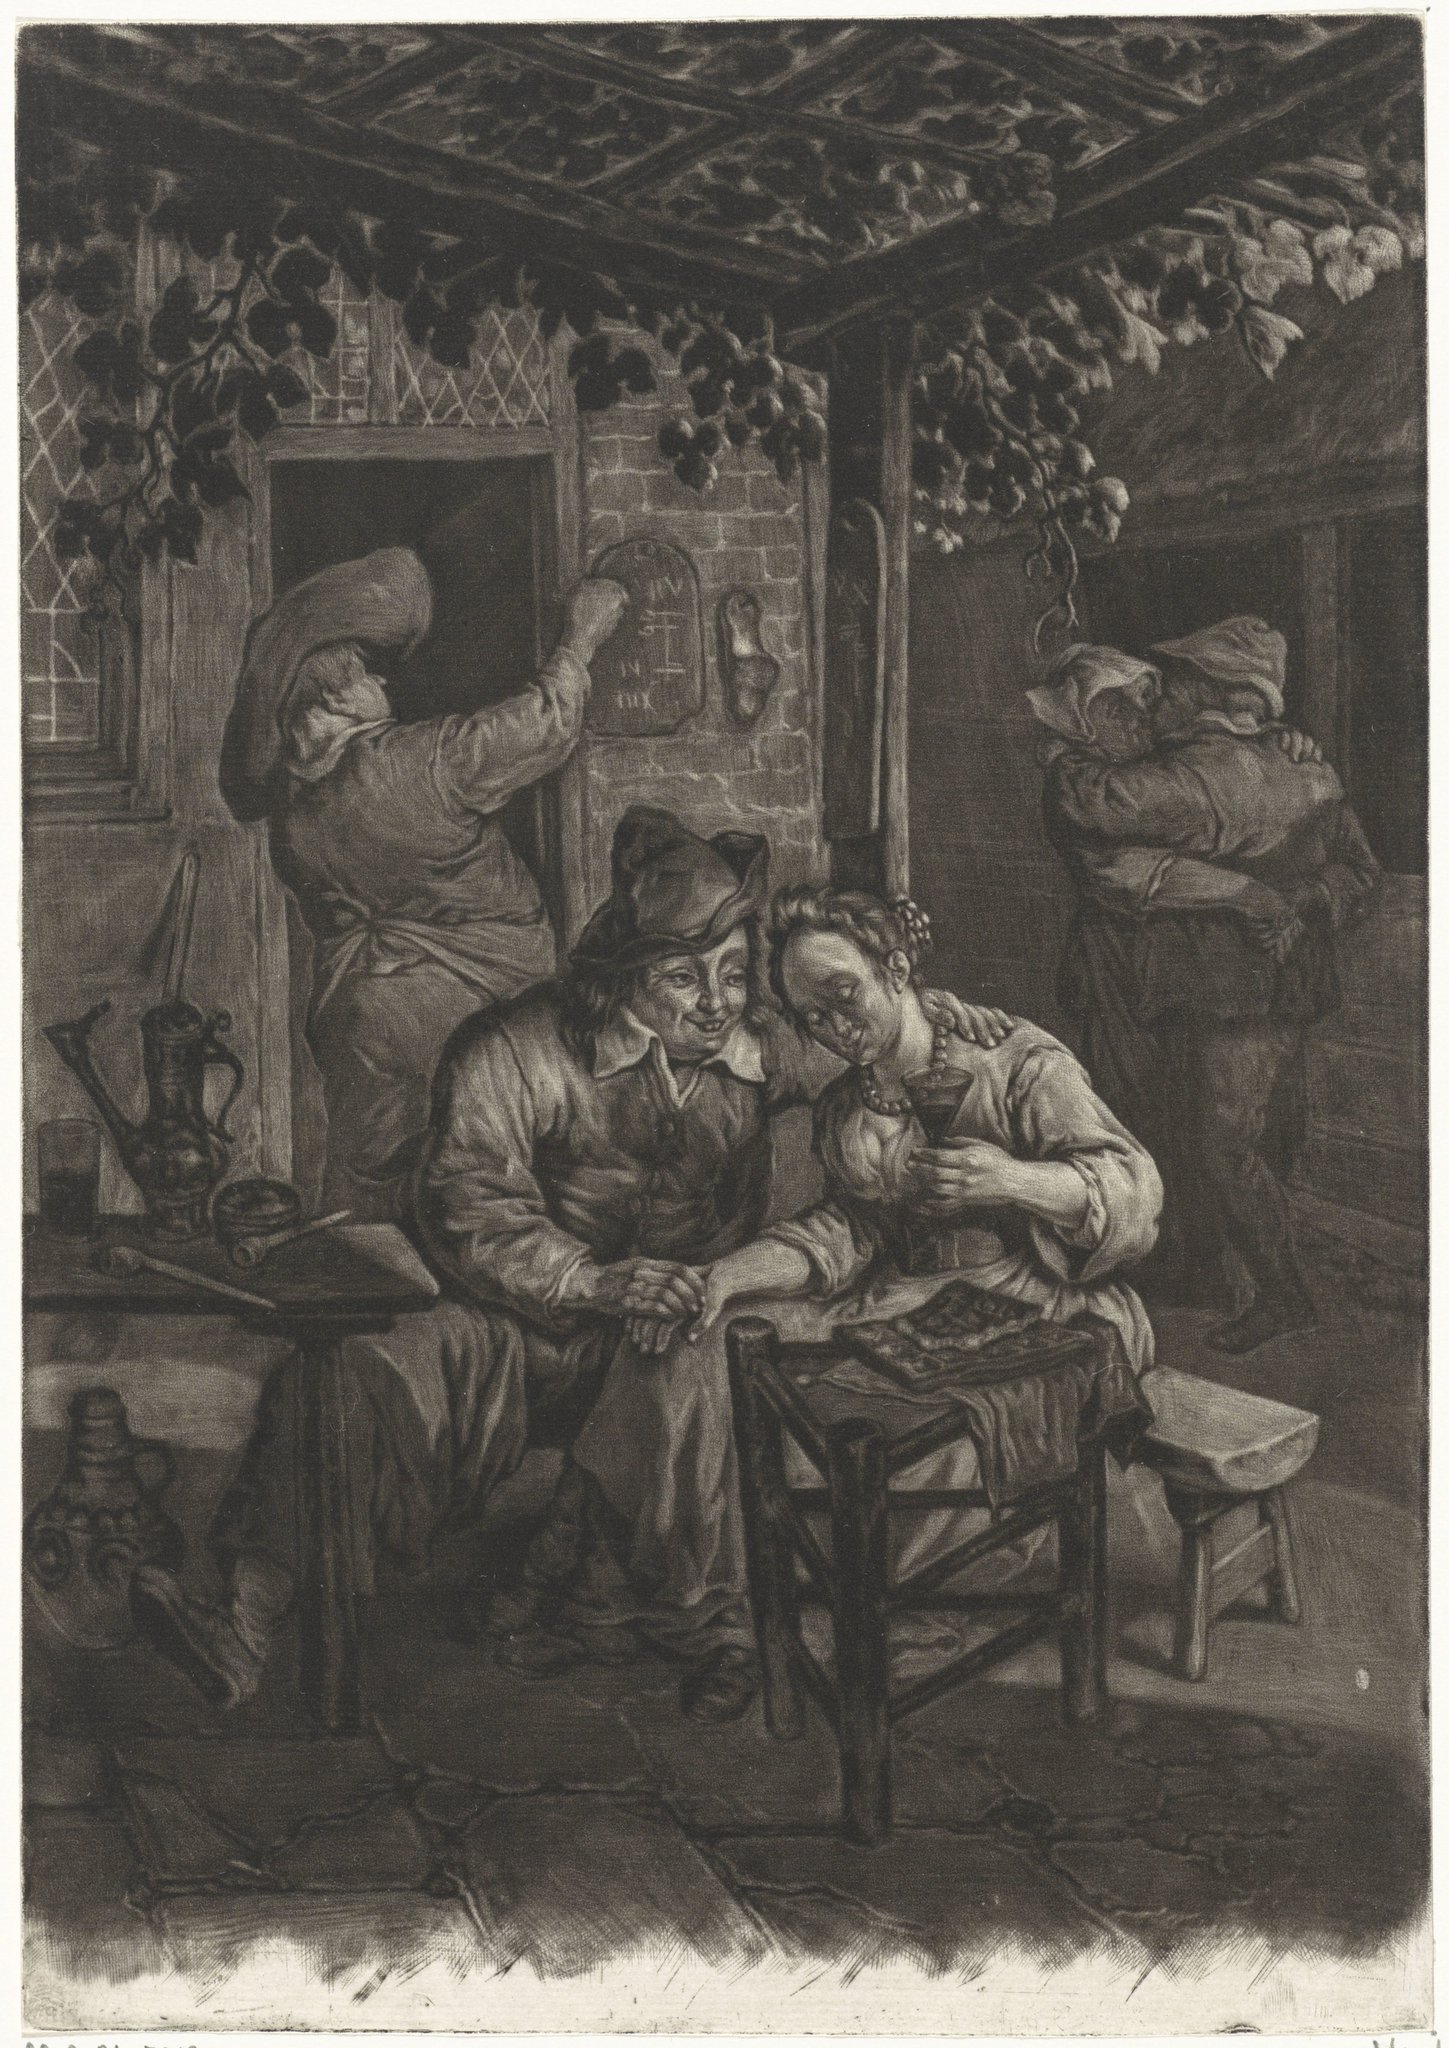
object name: print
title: De jeugd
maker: cornelis dusart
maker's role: draughtsman, painter, print maker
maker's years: 1660-1704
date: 1680-1704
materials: paper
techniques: mezzotint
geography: haarlem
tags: youth, adolescent, human life divided into stages, e.g. three, four, seven, twelve stages (with number), terrace, couple of lovers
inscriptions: collector's mark: Lugt 2228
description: Op een terras voor een herberg onder een pergola zit een jong liefdespaar in een intieme houding bij een tafel. Ze eten wafels en drinken wijn en bier. Op de achtergrond een tweede liefdespaar in een omhelzing. De prent is onderdeel van een reeks van vier prenten over de leeftijden van de mens.